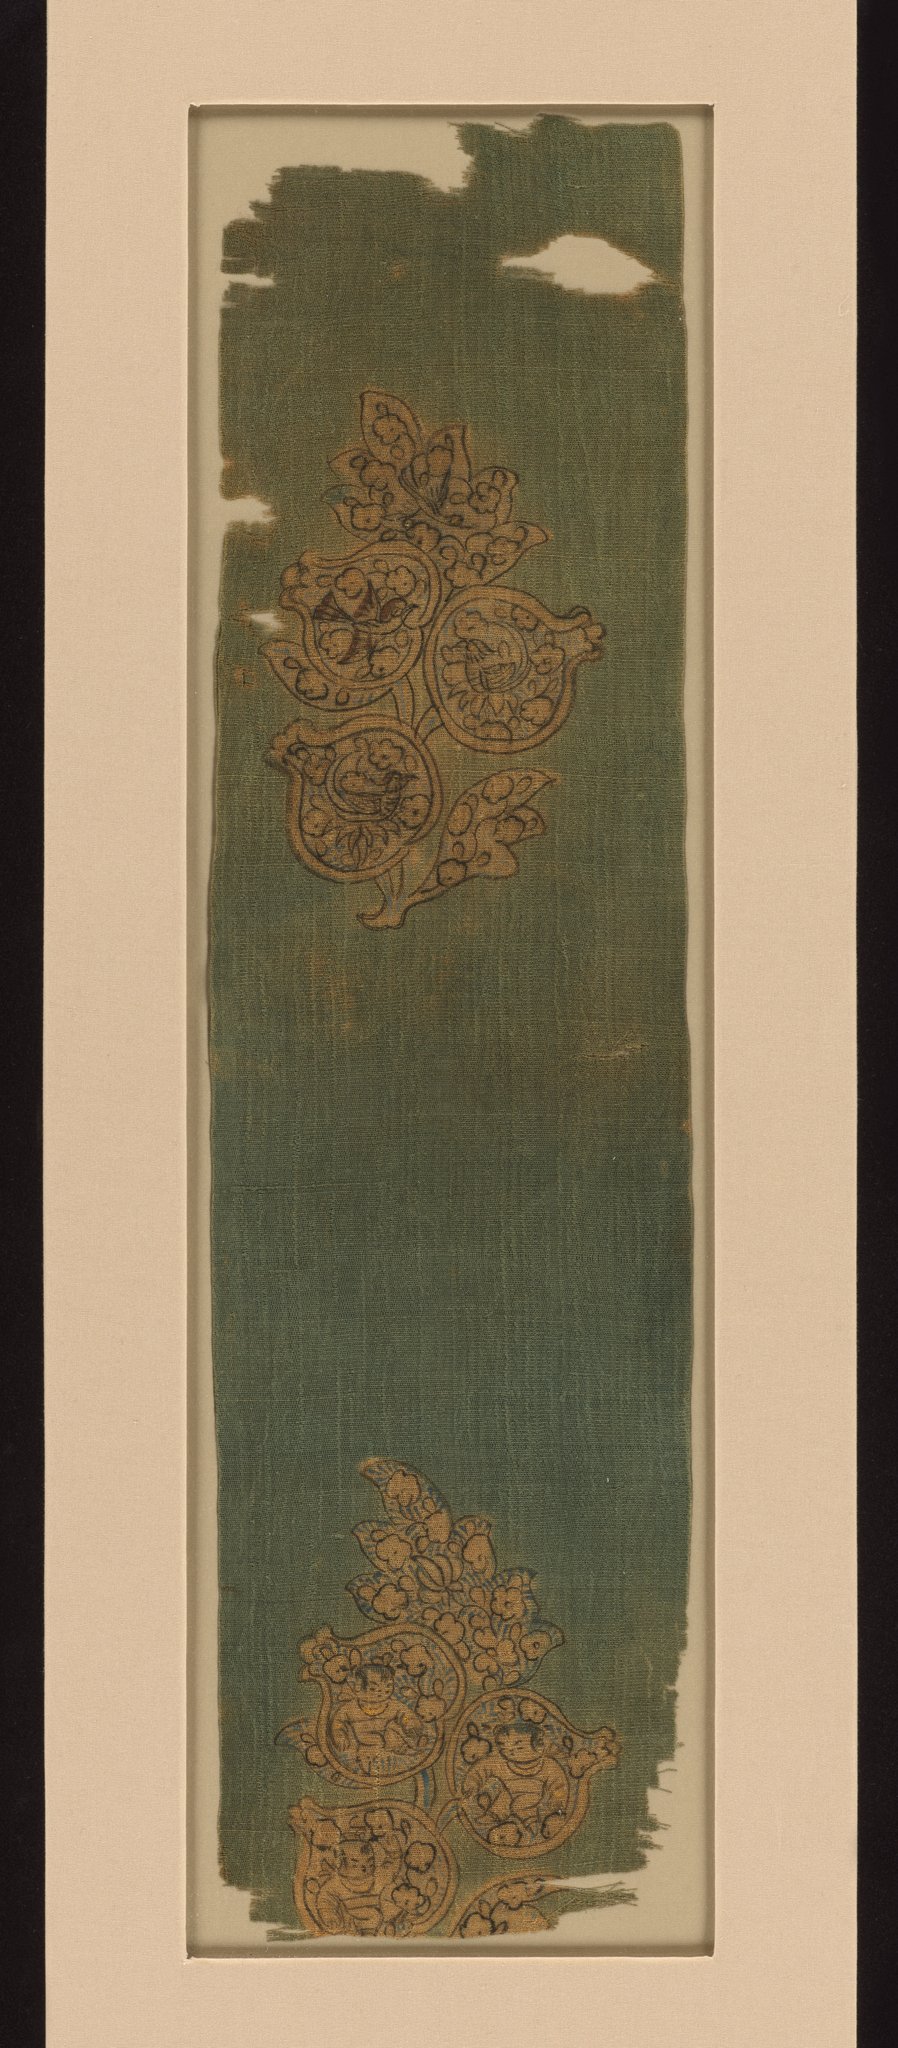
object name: textile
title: Textile fragment with boys and birds in pomegranates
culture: chinese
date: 901-1000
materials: textile, silk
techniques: painting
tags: pomegranates,boys